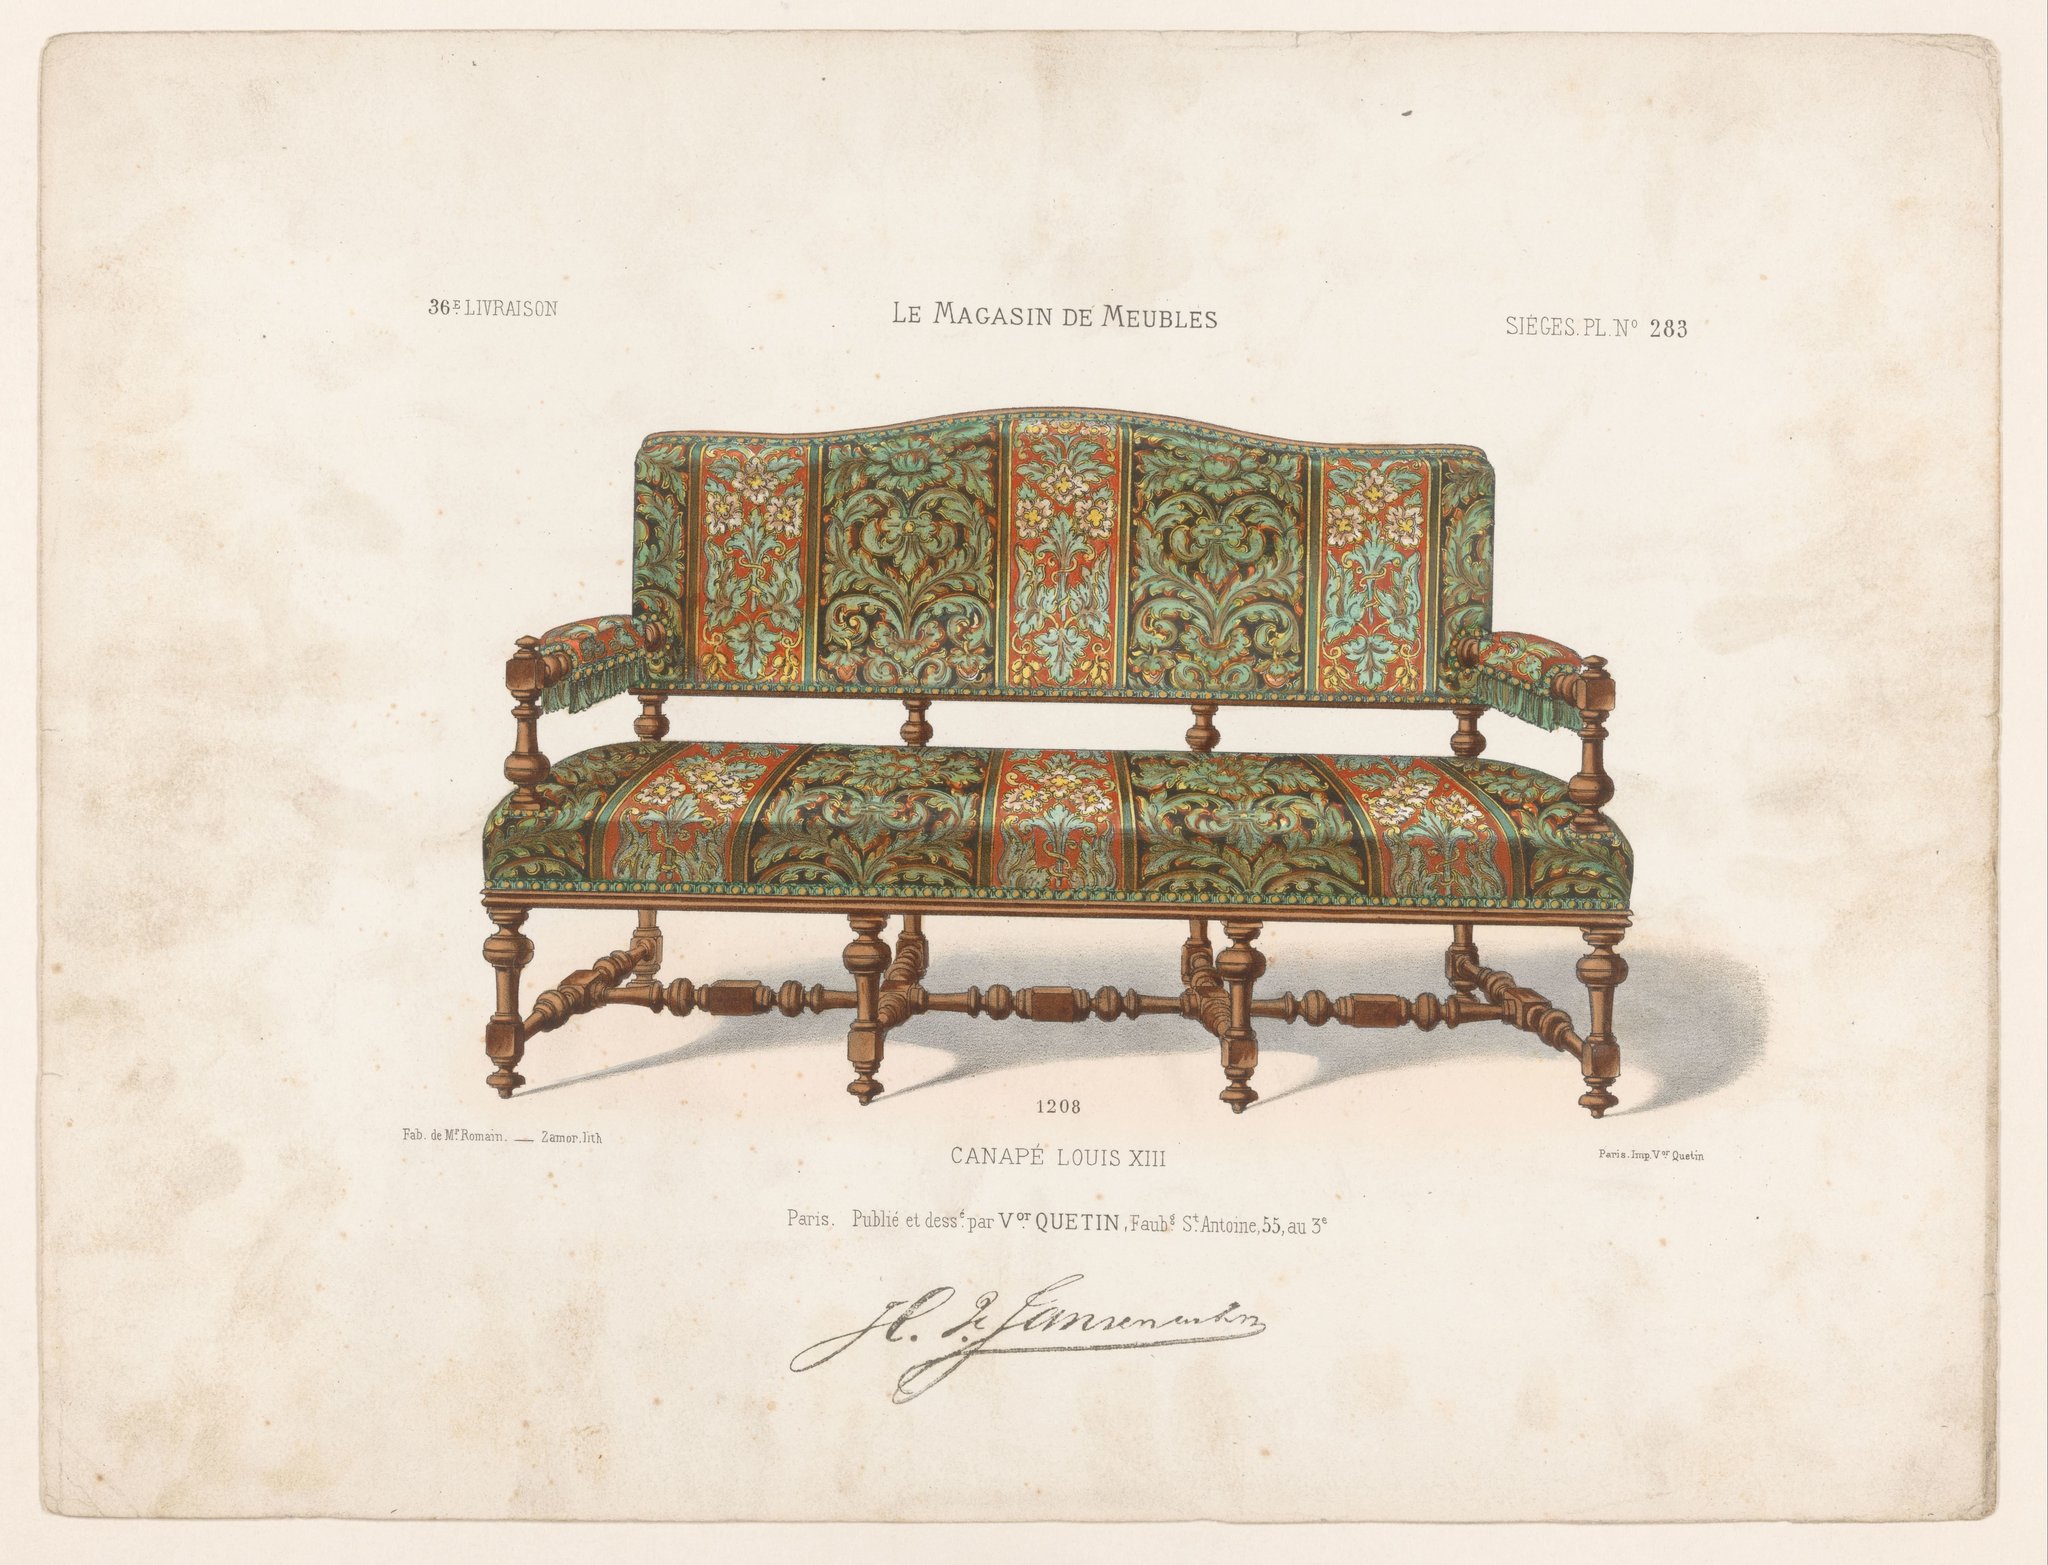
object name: print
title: Canapé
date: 1832-1877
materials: paper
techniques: hand coloring, lithograph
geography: paris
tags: seating furniture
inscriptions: stamp: ‘H.F. Jansen en Zn’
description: Een canapé in de Lodewijk XIII-stijl. Prent uit 36e Livraison.